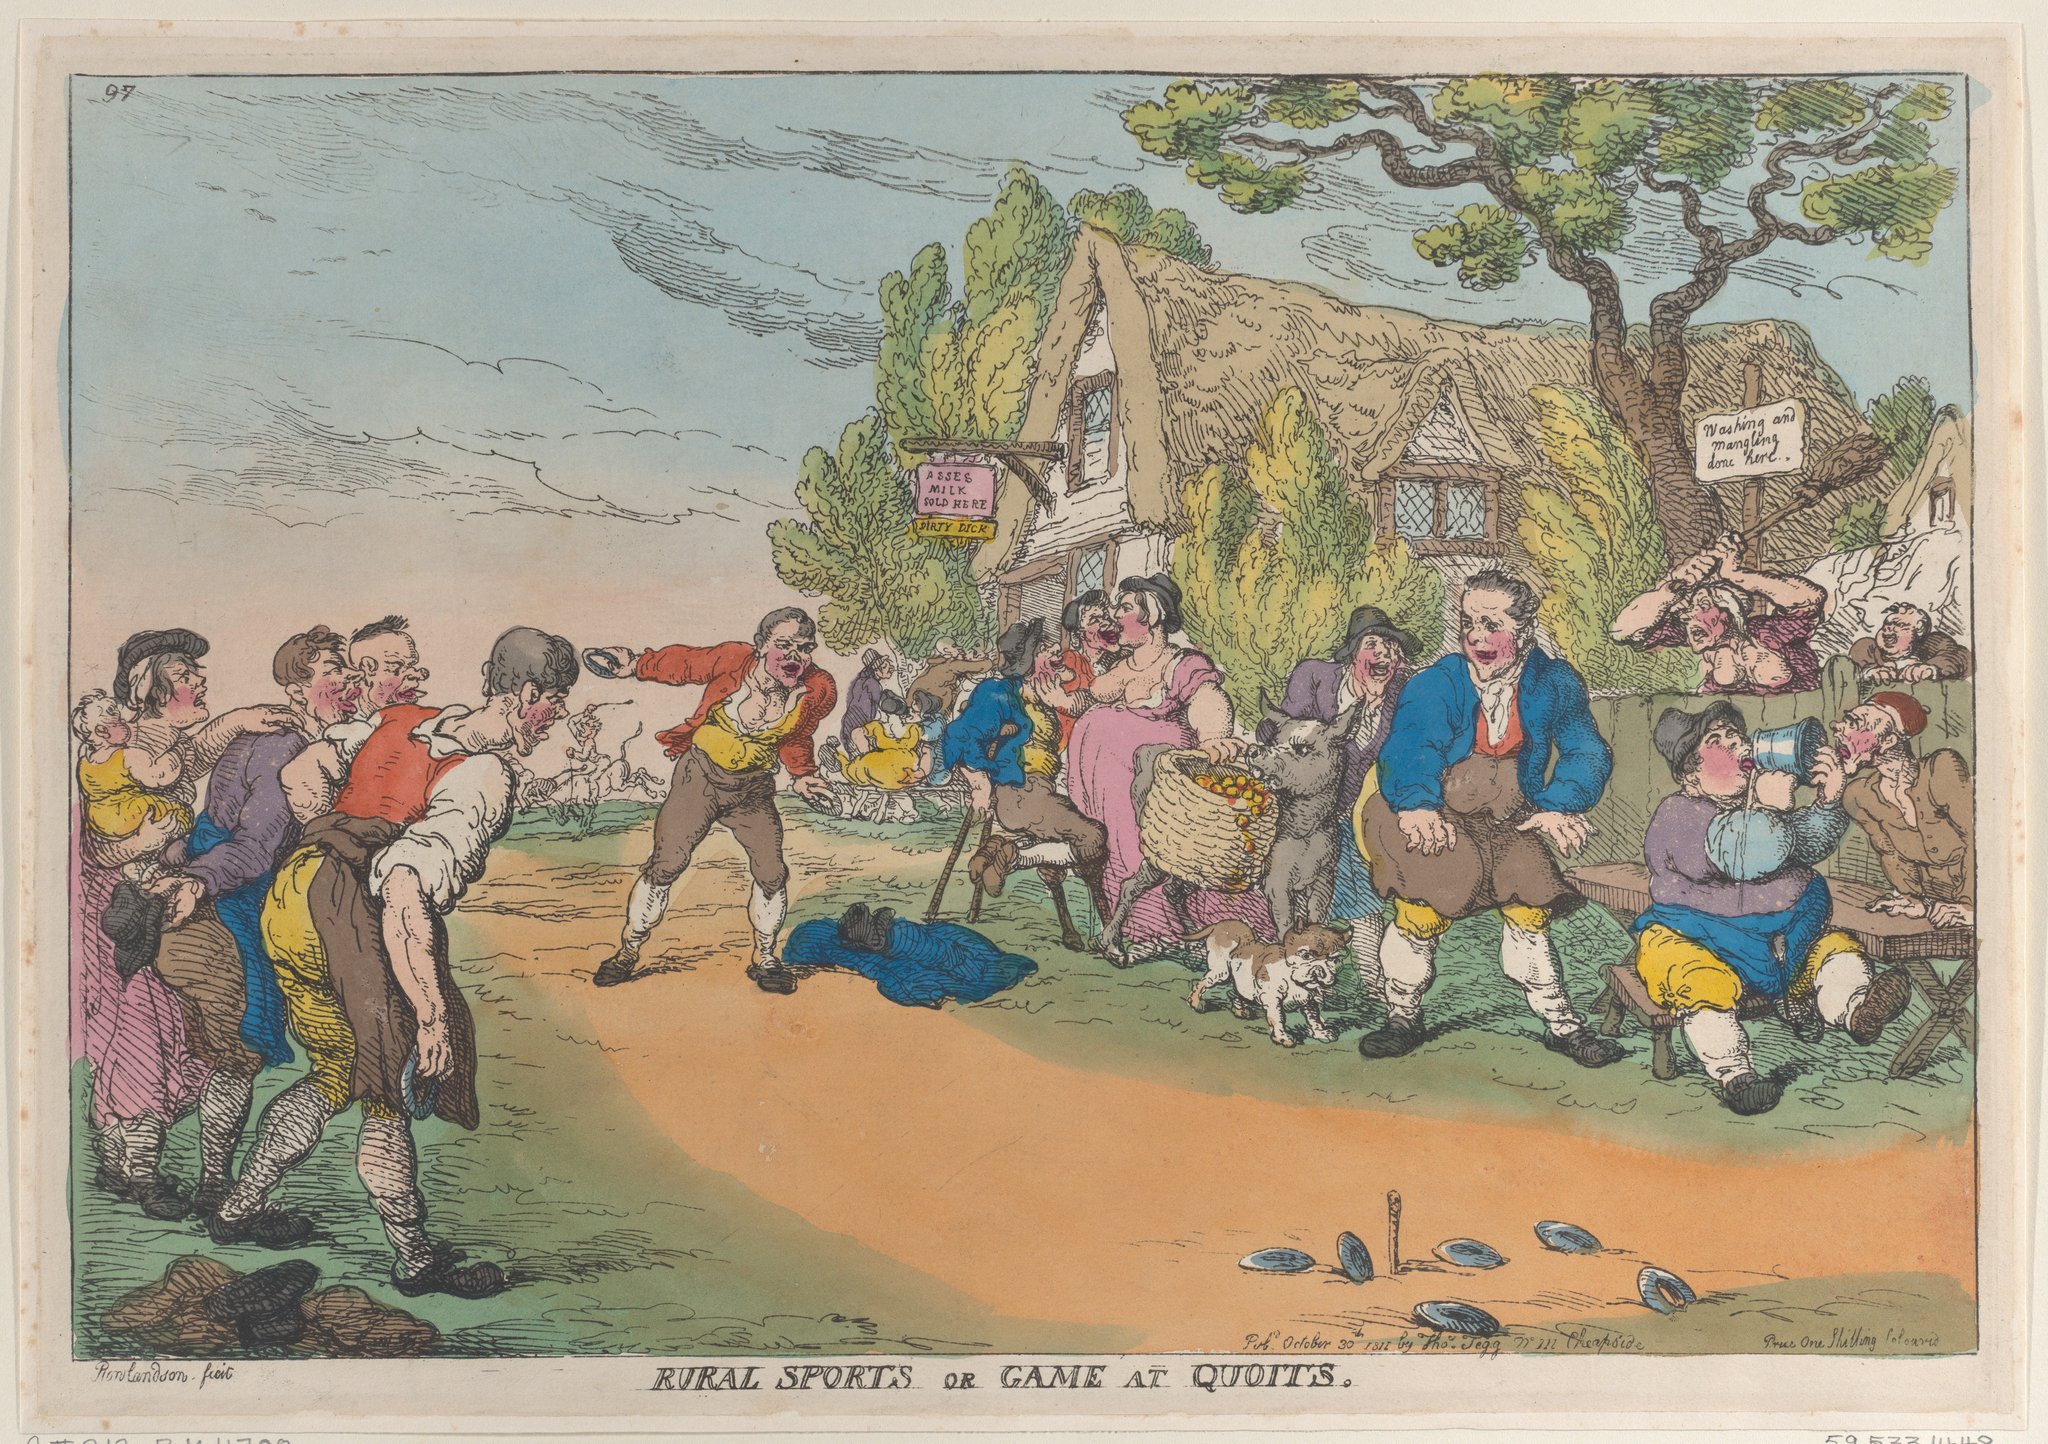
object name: print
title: Rural Sports or Game at Quoits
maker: thomas rowlandson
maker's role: artist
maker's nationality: british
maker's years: 1757-1827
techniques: etching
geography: london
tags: satire,men,women,games